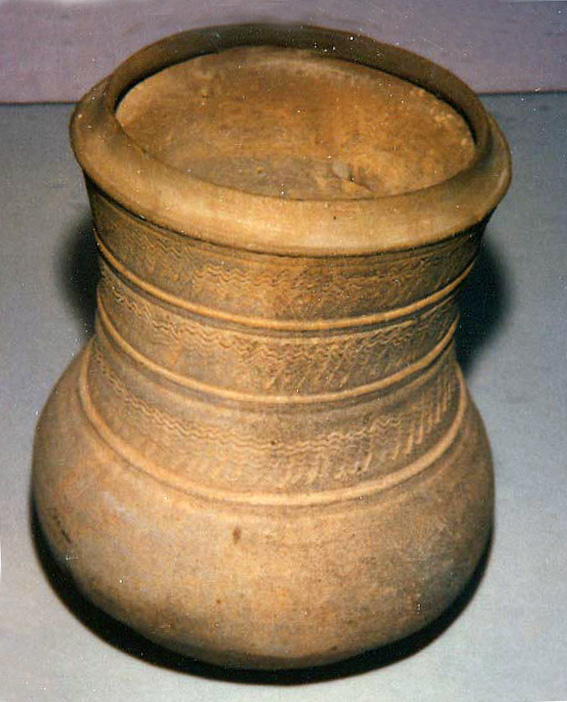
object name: jar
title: Bell-Shaped Jar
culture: korean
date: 401-700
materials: pottery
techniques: firing